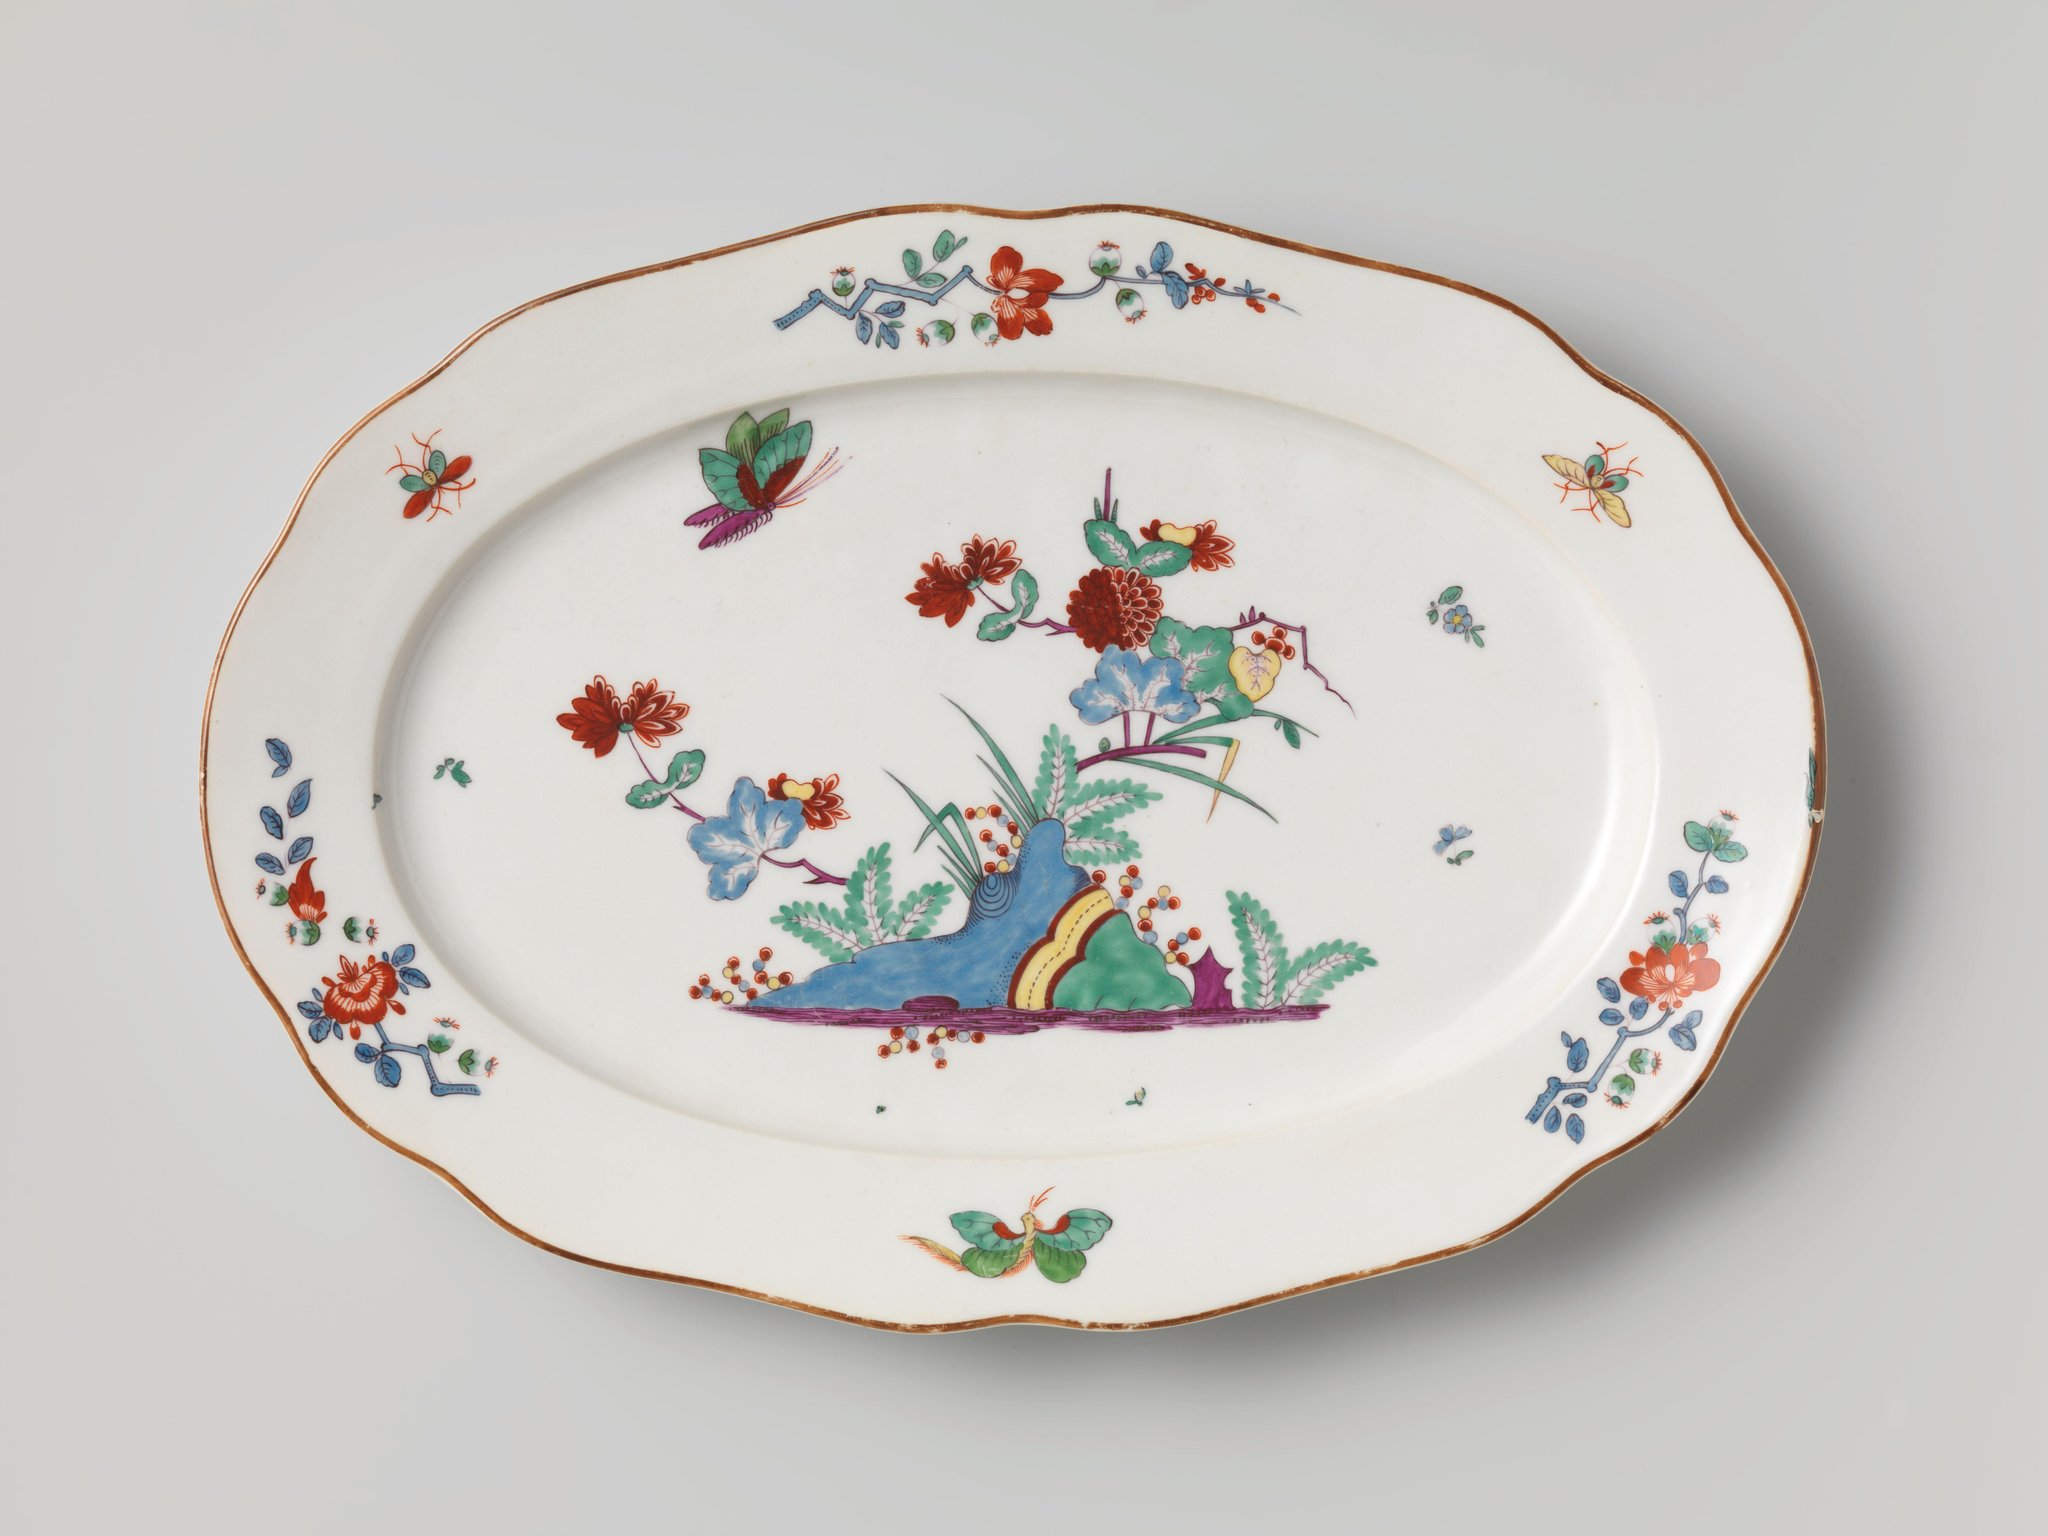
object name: service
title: Schotel van porselein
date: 1784-1786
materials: porcelain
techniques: painted, polychromy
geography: oud-loosdrecht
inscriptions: signature and date: ‘M.O.L. en Amstel’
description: Dutch Delftware and porcelain after Japanese Kakiemon. Oval dish. Porcelain.Ouder-Amstel, factory under Johann Friedrich Daeuber, c. 1784 - 1786.